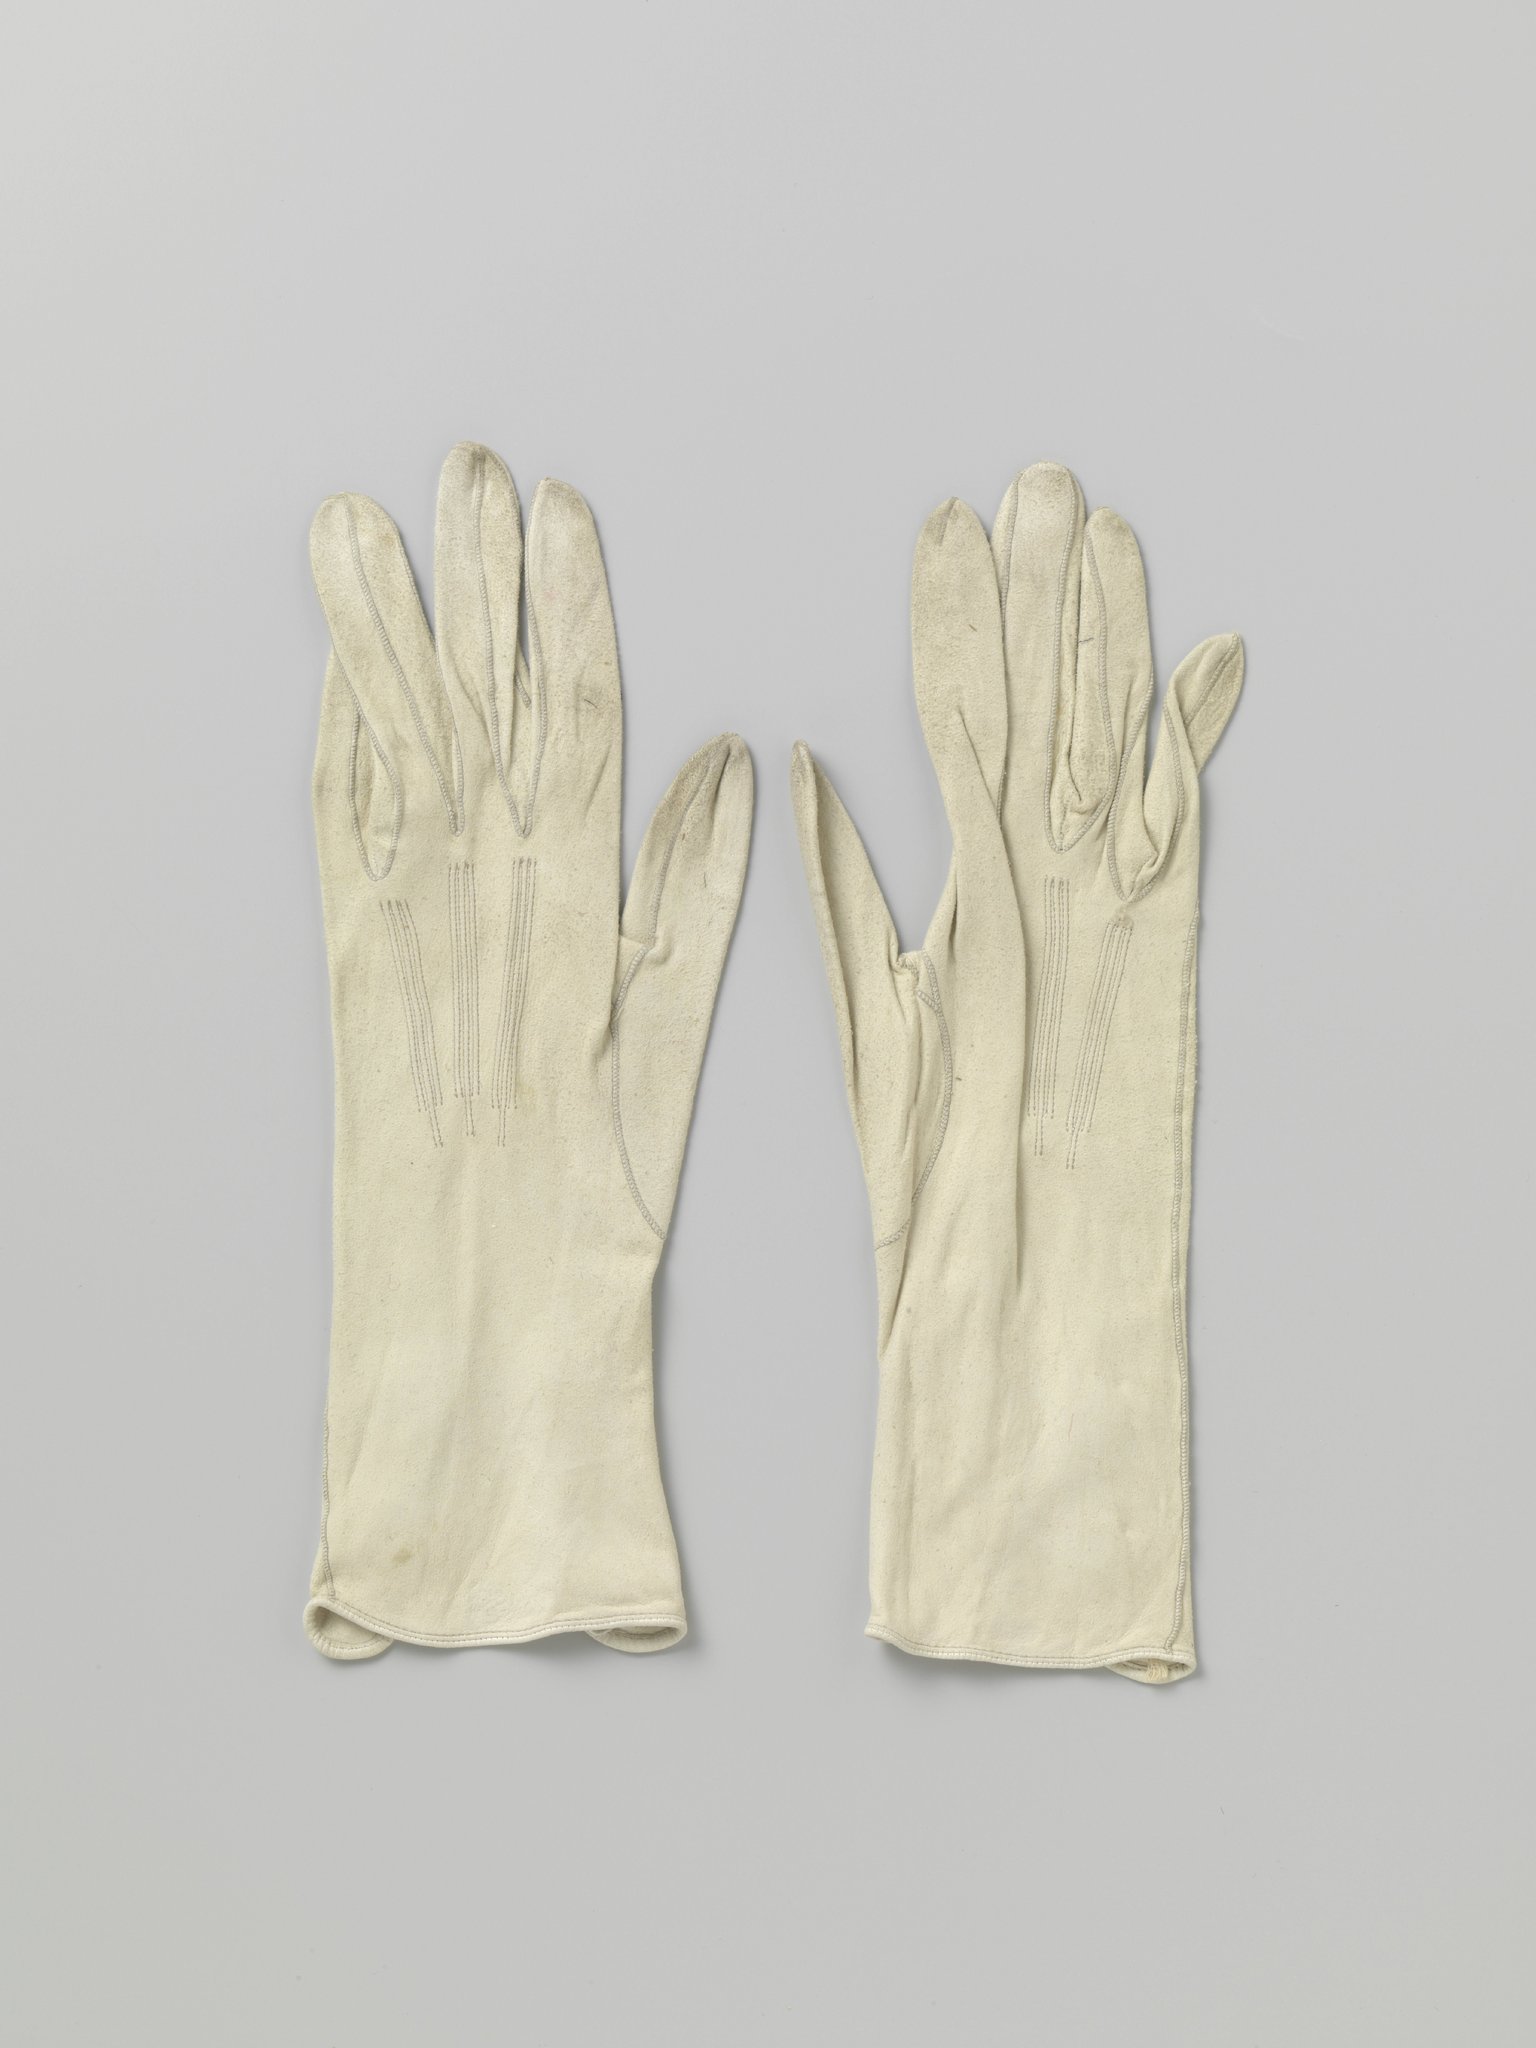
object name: glove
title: Handschoen van naturel wasleer met twee parelmoer drukknopen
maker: Anonymous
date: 1900-1950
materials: leather, mother of pearl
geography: netherlands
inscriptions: : ‘cijfers’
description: Rechter handschoenen van naturel wasleer met twee parelmoer drukknopen en op de rug drie uitstralende koorden.